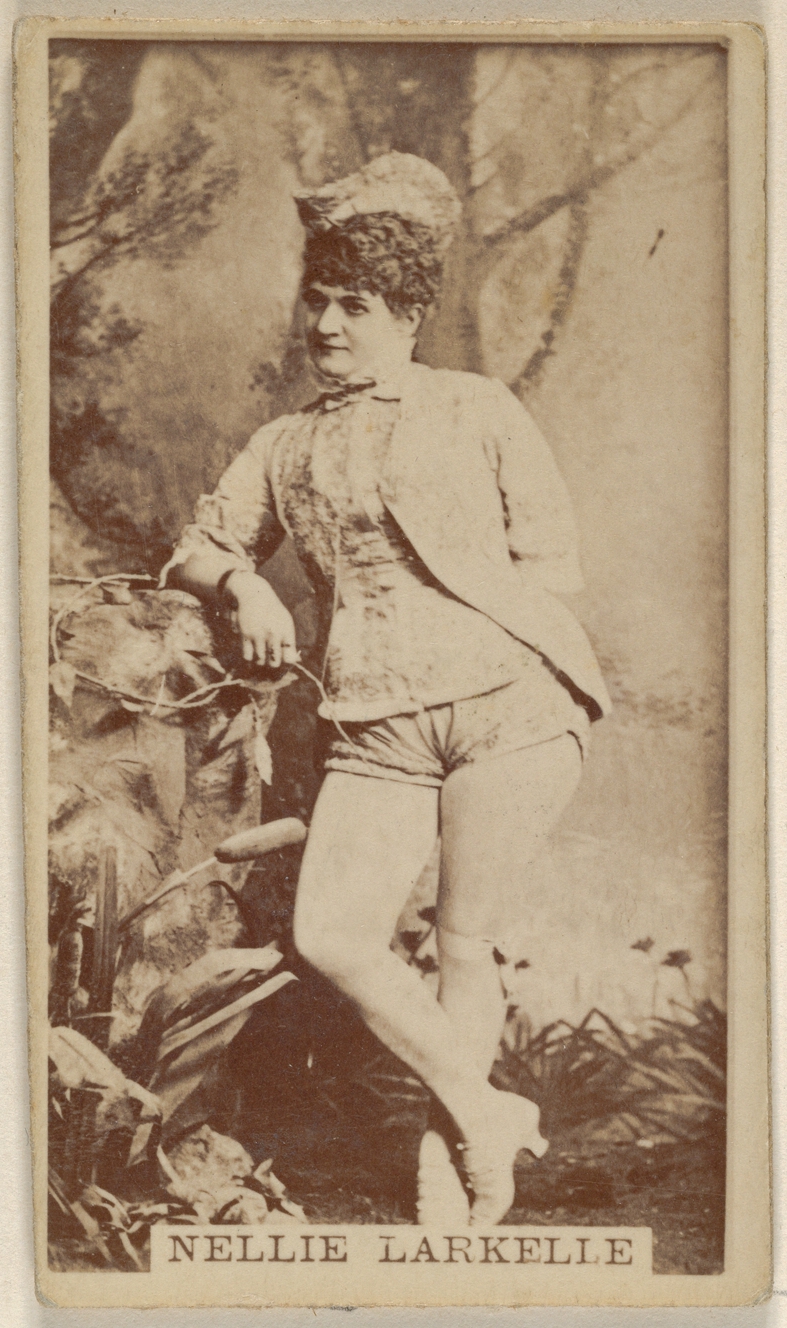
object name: photograph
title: Nellie Larkelle, from the Actors and Actresses series (N45, Type 8) for Virginia Brights Cigarettes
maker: allen & ginter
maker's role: publisher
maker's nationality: american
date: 1888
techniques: albumen silver print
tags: portraits,women,actresses